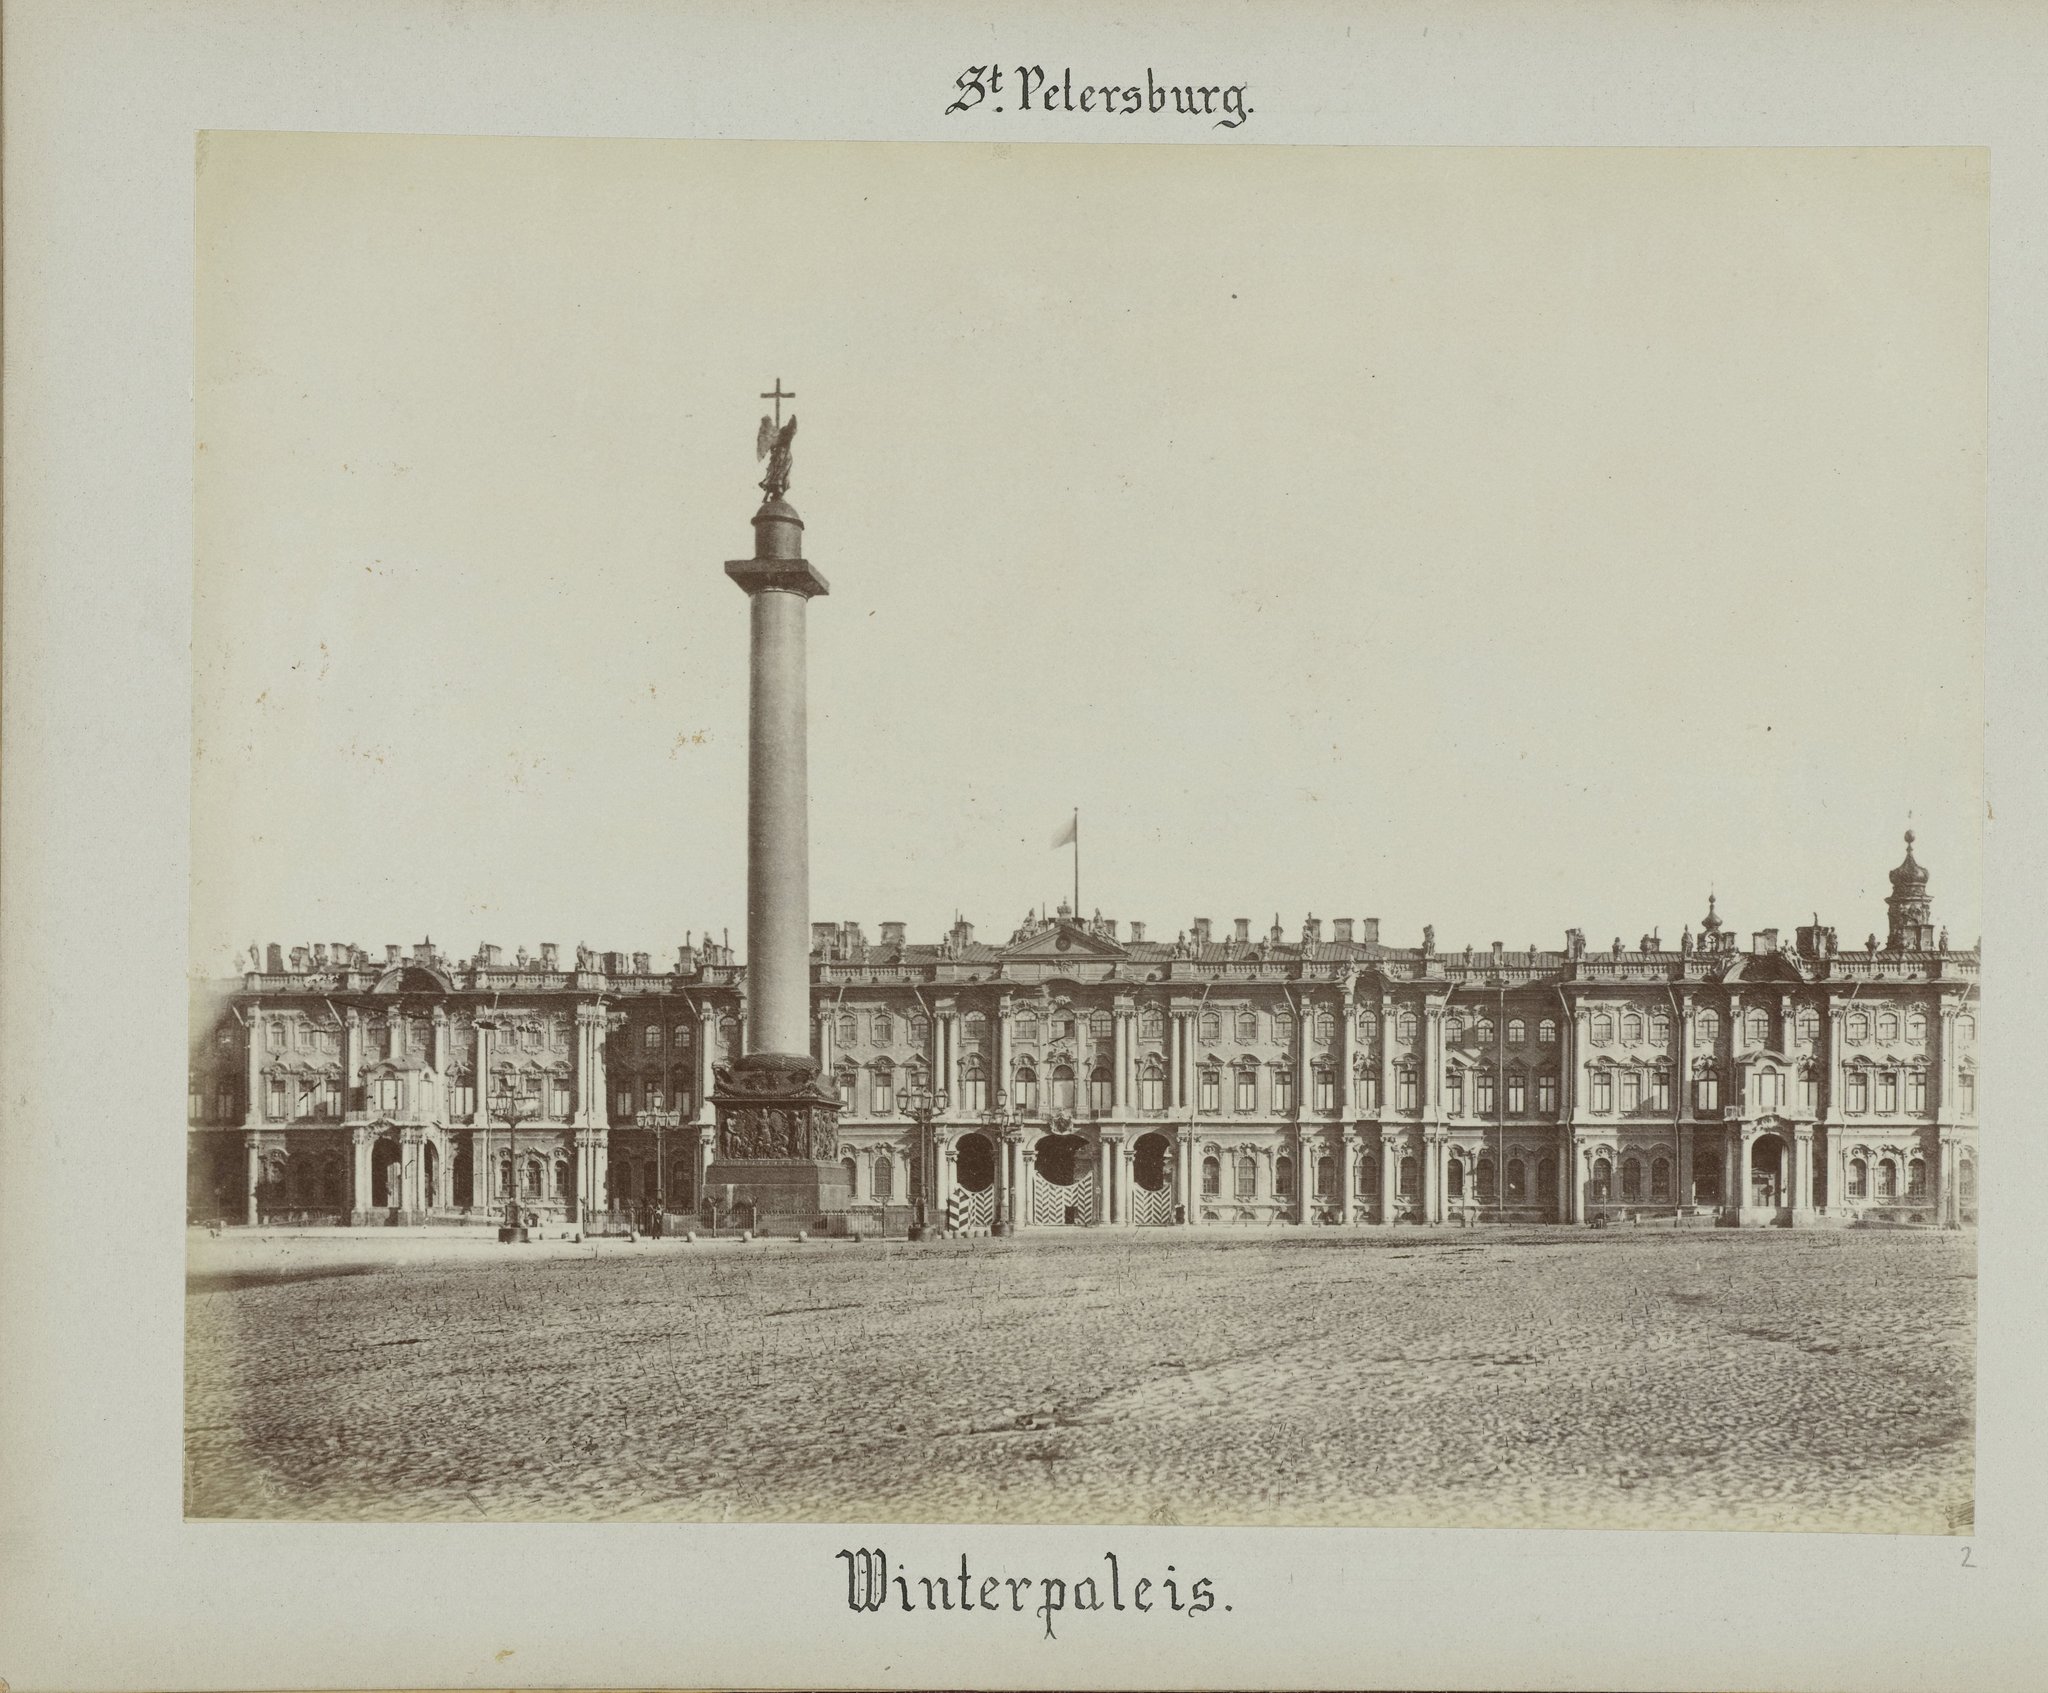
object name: photograph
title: Hermitage in Sint-Petersburg met voor het paleis de Alexander kolom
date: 1898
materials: paper, photographic support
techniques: albumen print